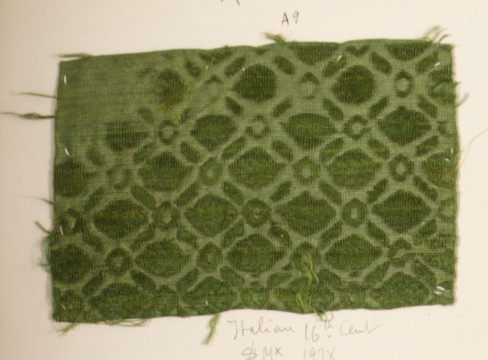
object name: fragment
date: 1501-1600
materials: silk